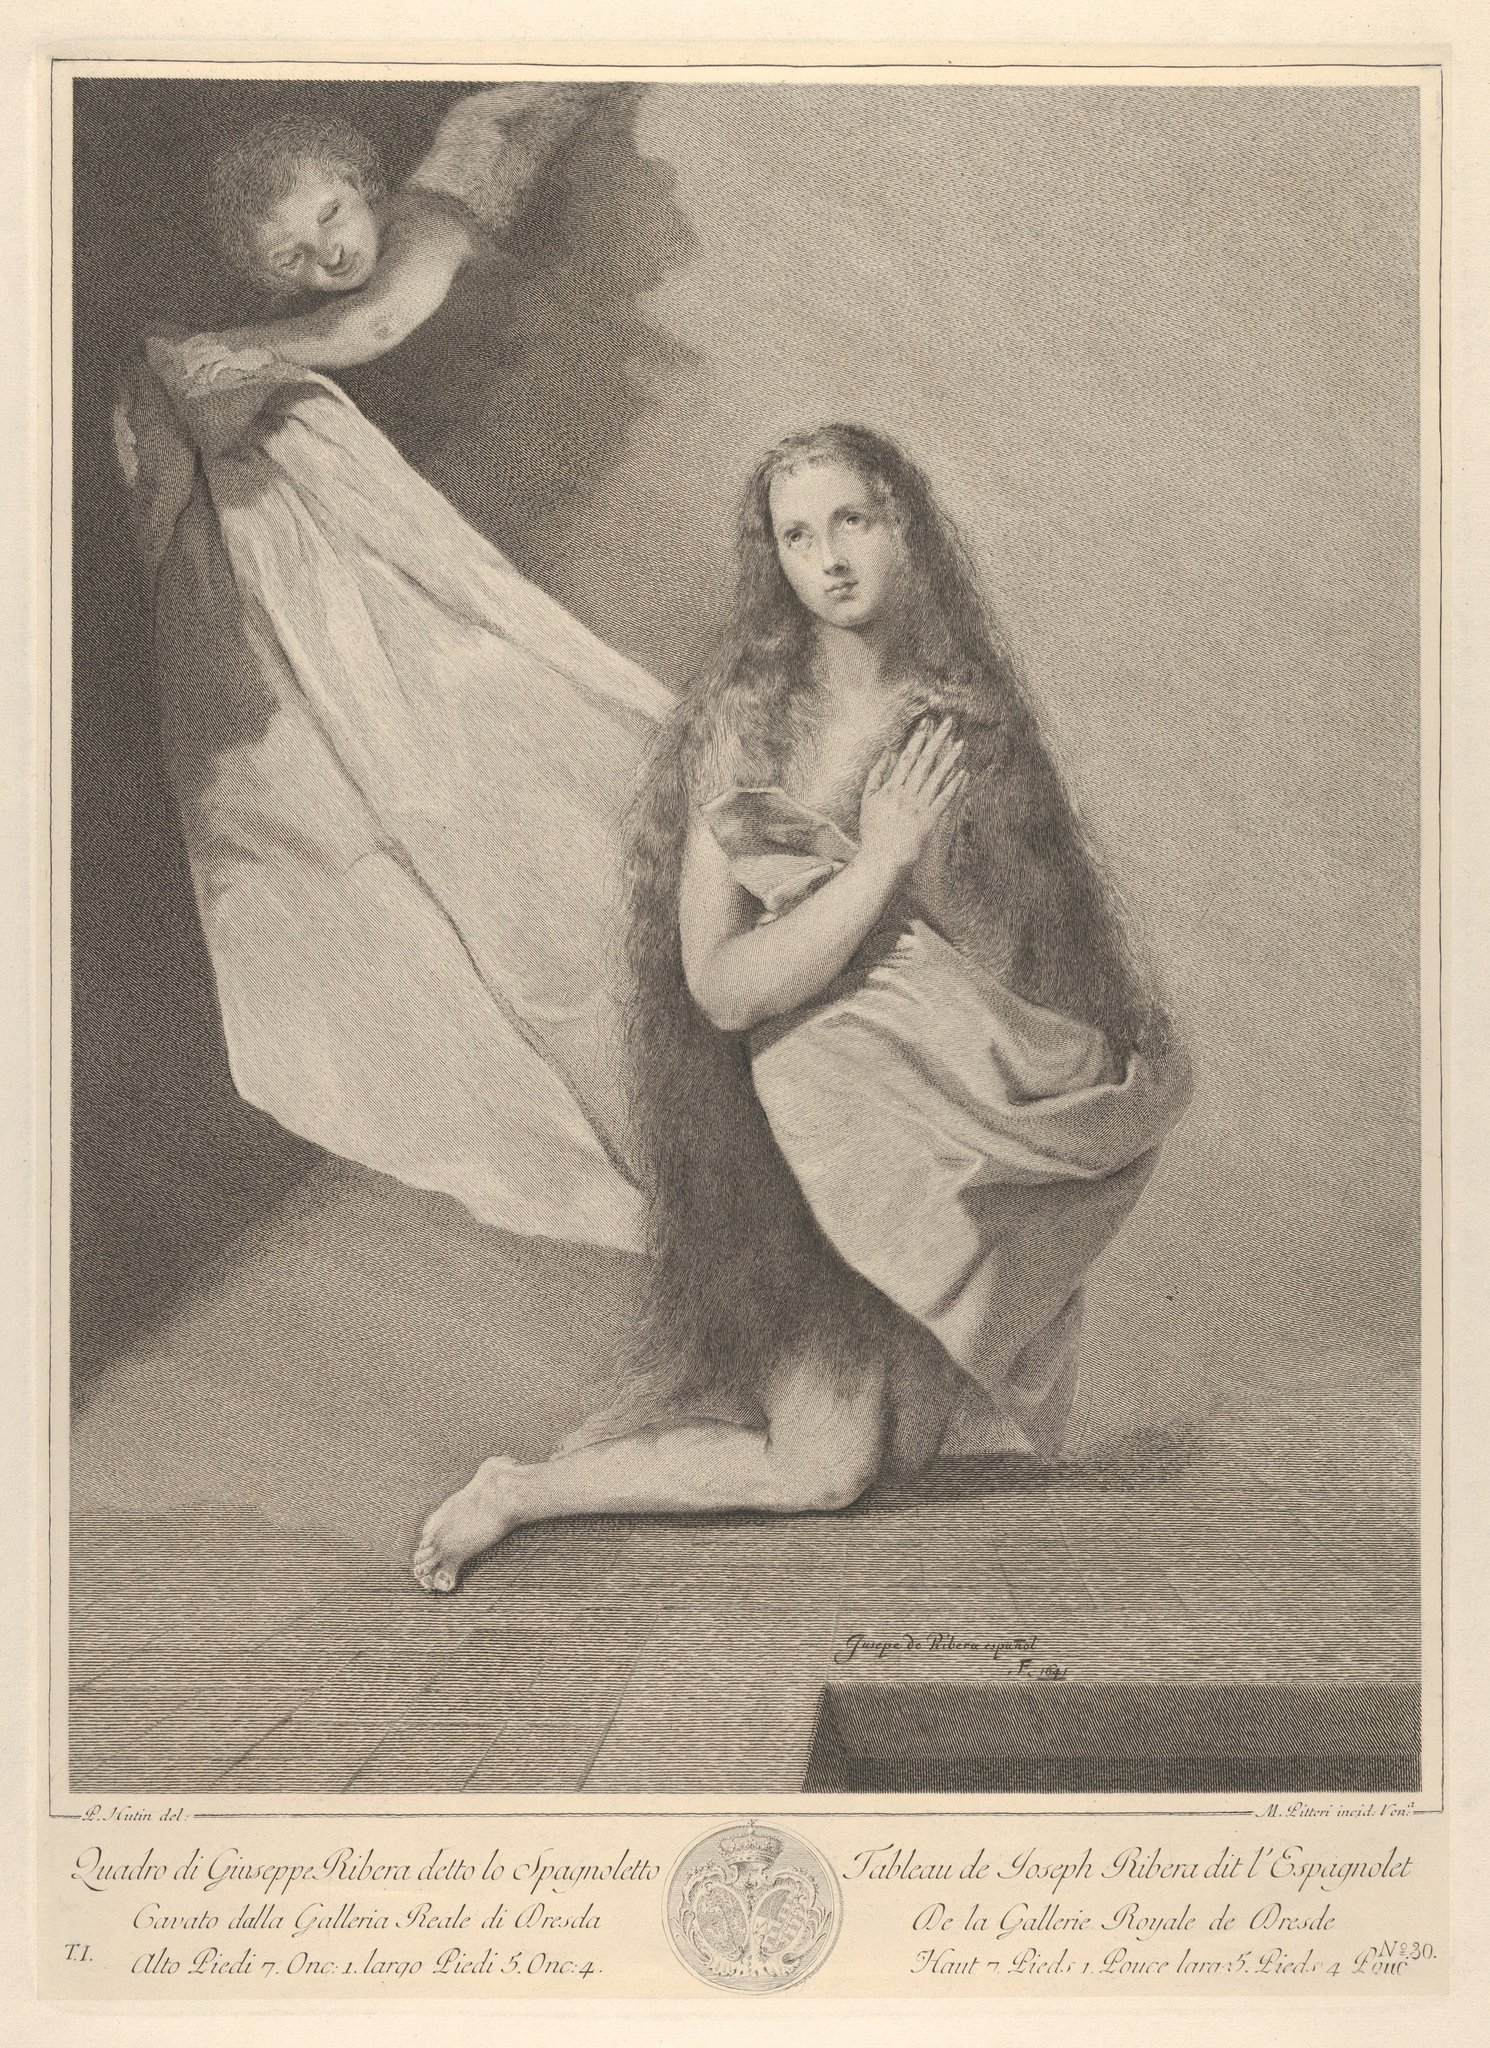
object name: print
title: The Magdalene kneeling, from 'Recueil d'estampes d'après les plus célèbres tableaux de la Galerie Royale de Dresde'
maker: marco alvise pitteri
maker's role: engraver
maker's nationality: italian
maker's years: 1702-1786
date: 1730-1786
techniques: printmaking, engraving, etching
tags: angels,mary magdalene,coat of arms